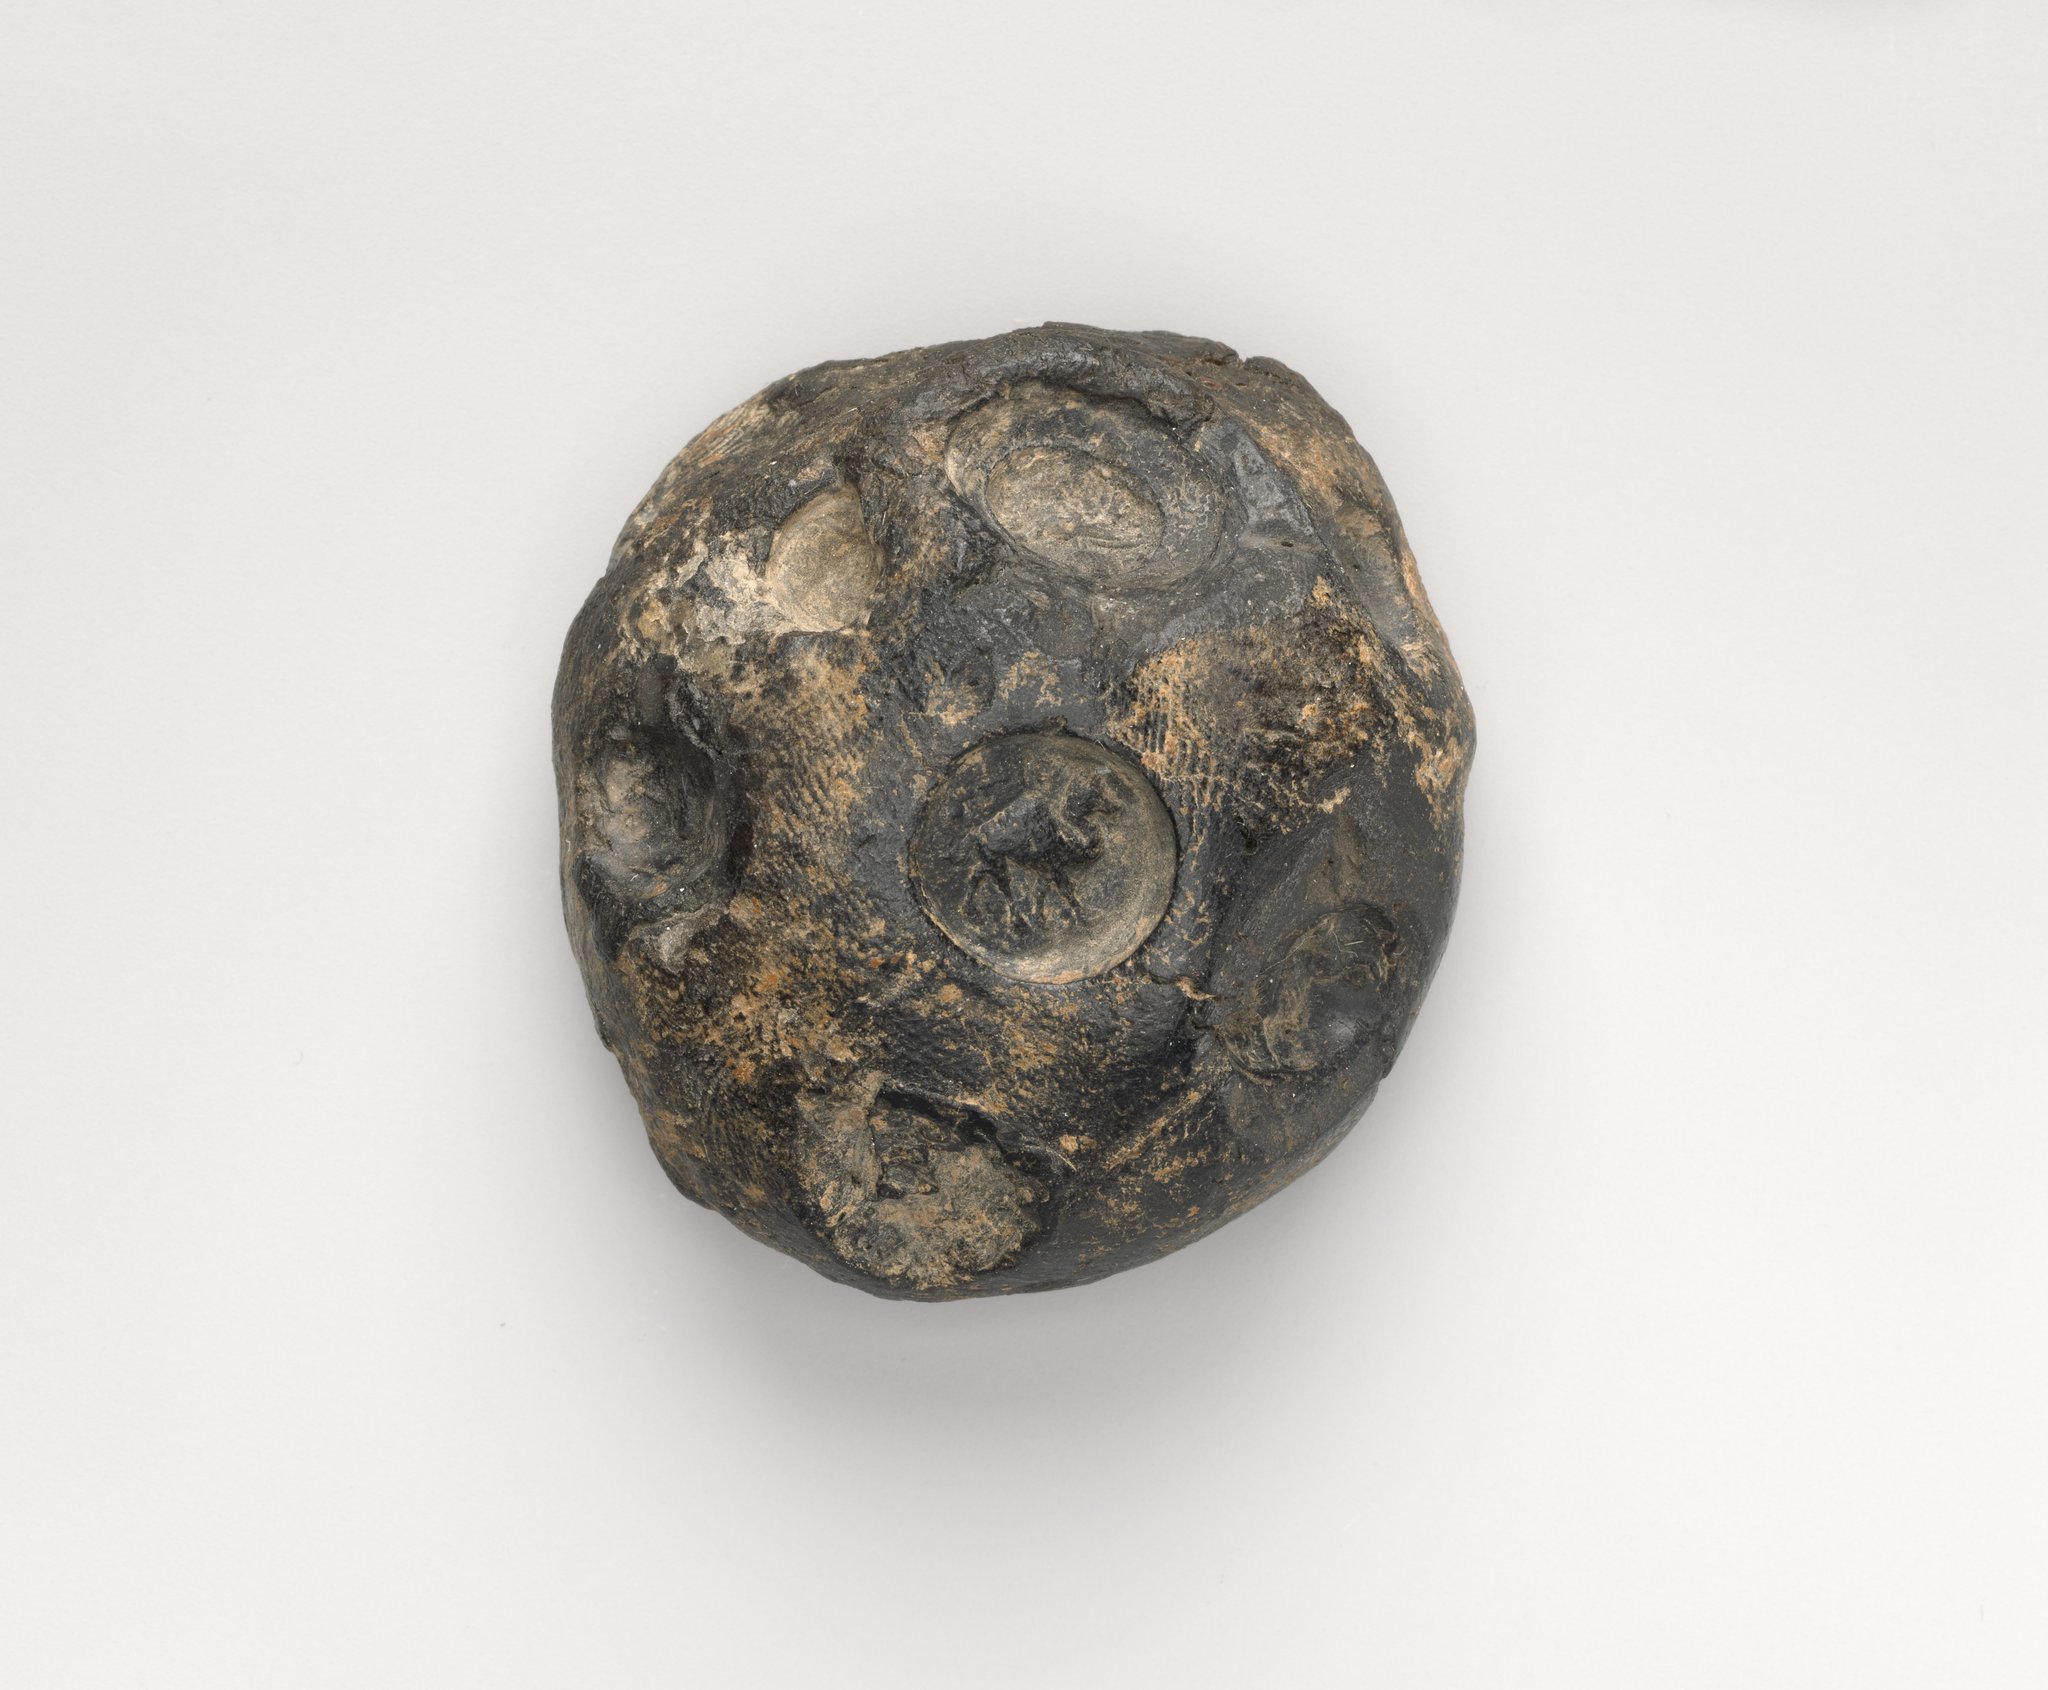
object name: sealing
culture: sasanian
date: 601-700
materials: clay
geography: iran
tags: camels